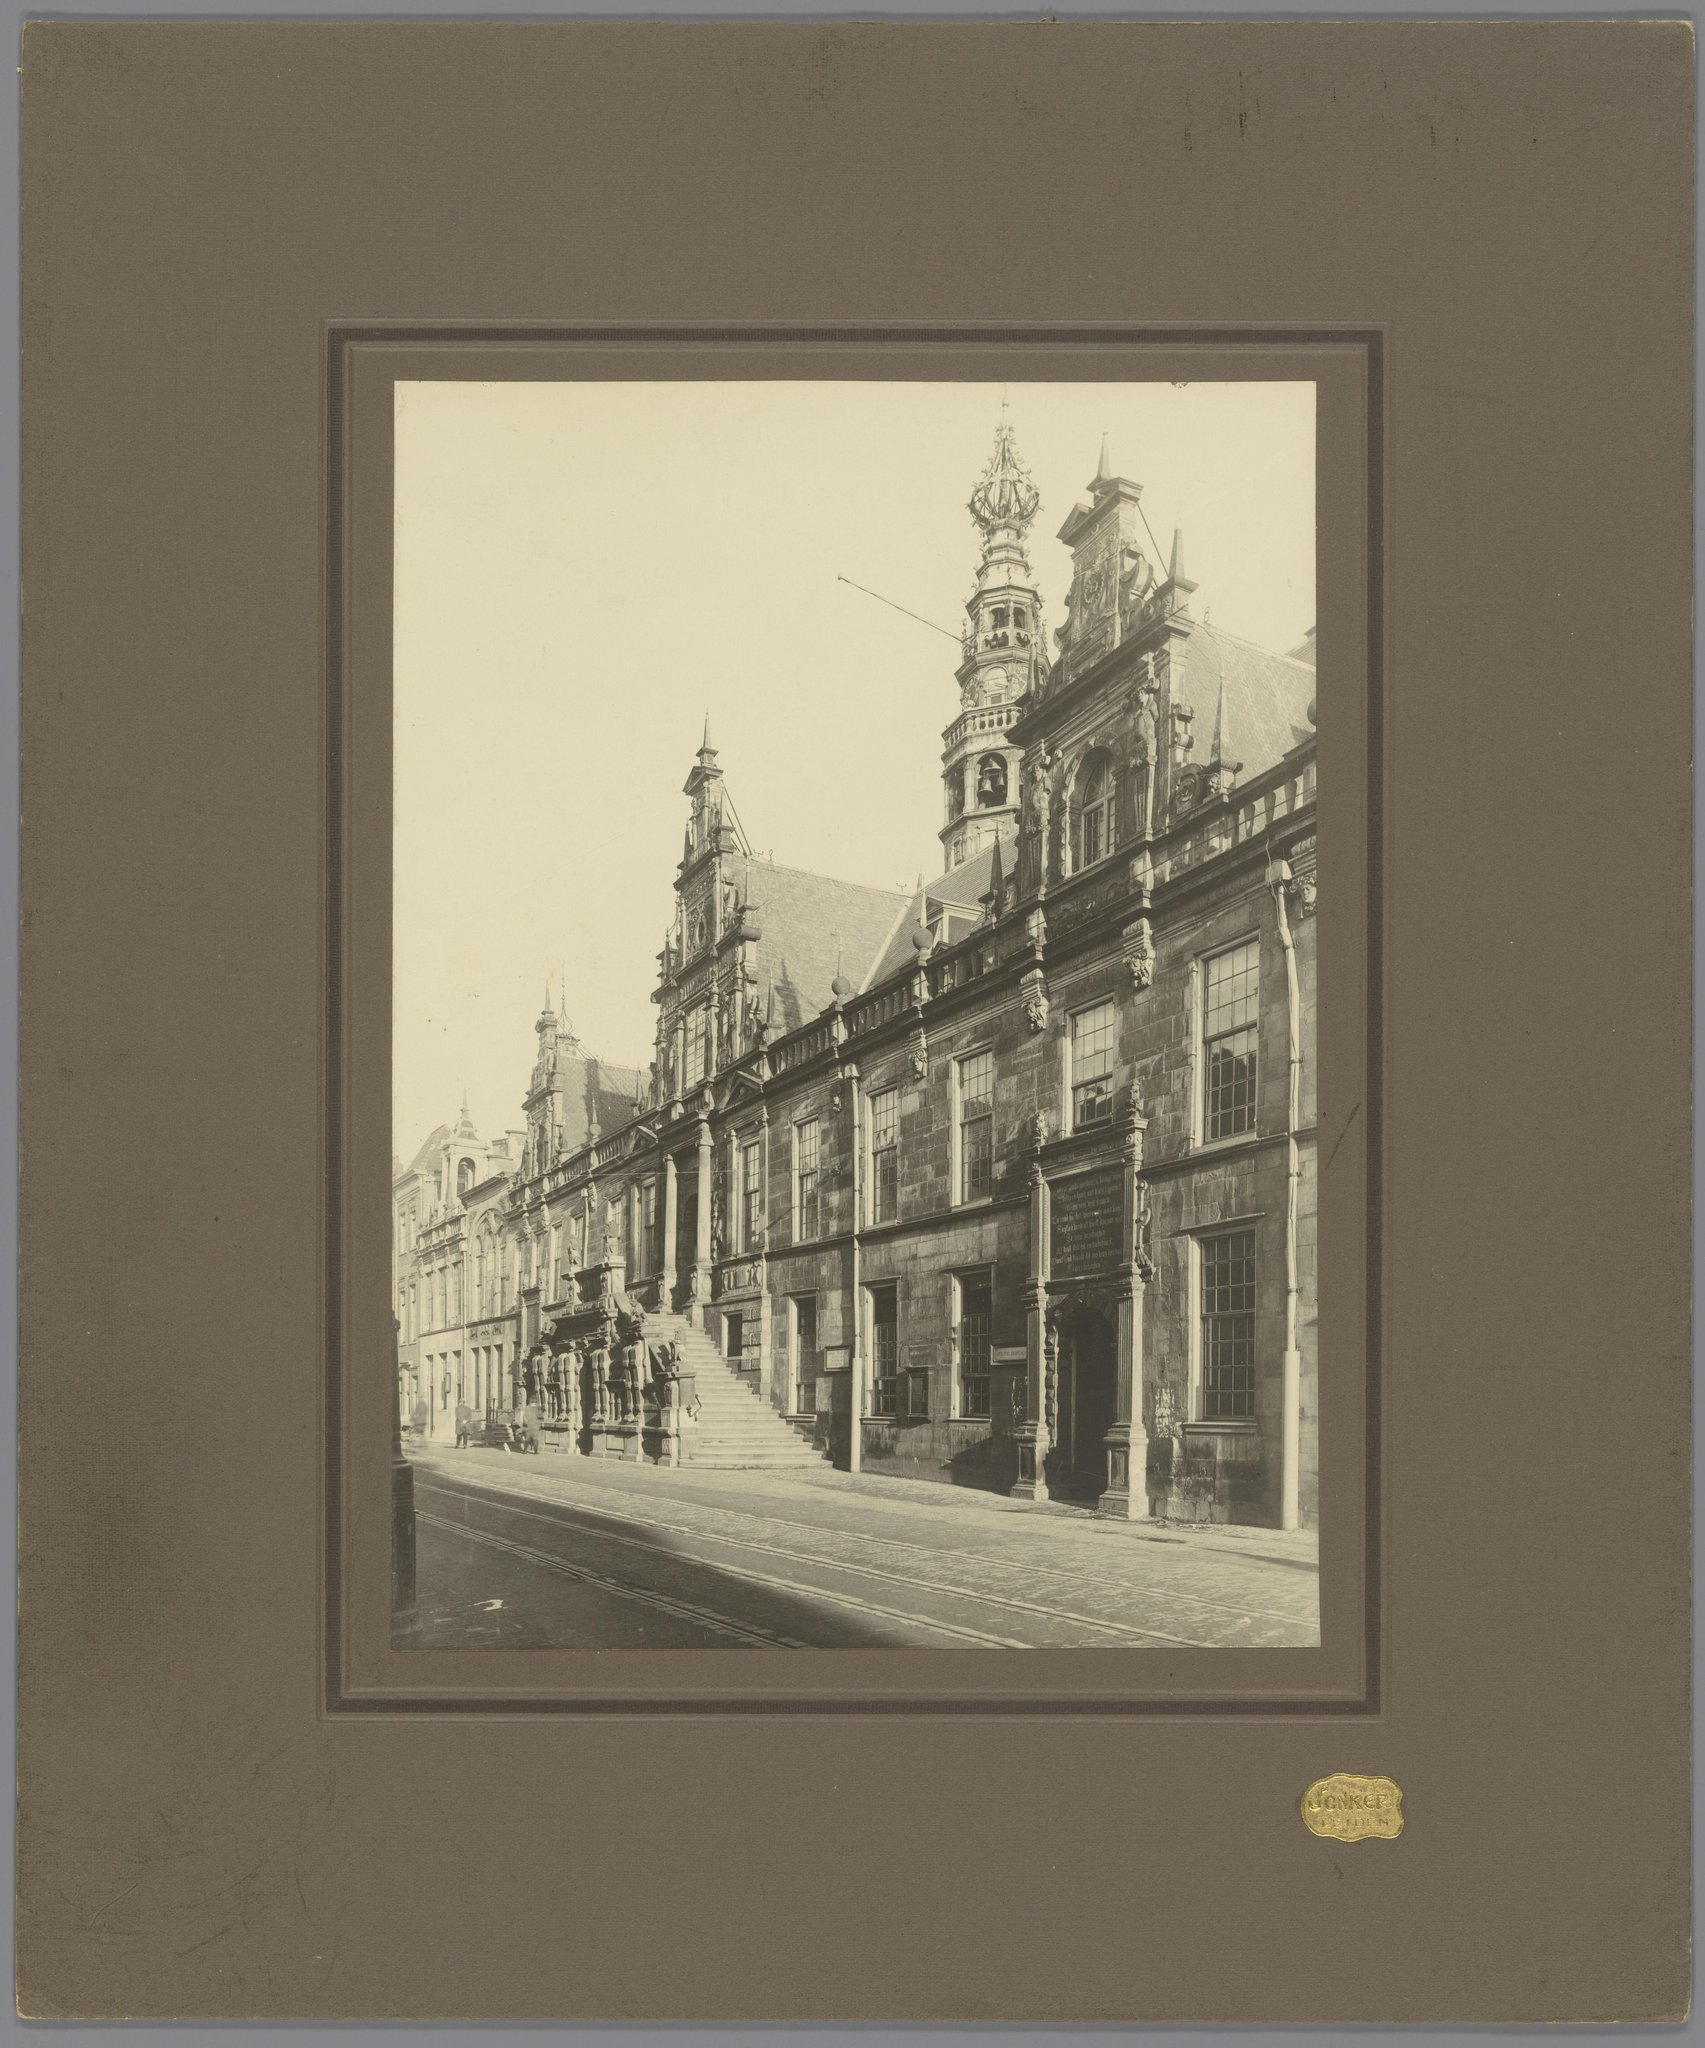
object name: photograph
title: Gezicht op het stadhuis te Leiden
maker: hendrik jonker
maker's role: fotograaf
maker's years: 1846-1932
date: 1882-1920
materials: cardboard, photographic support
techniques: collodion silver print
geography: leiden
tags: townhall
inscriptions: inscription: ‘Vosmaer’, inscription: ‘Jonker/ Leiden’